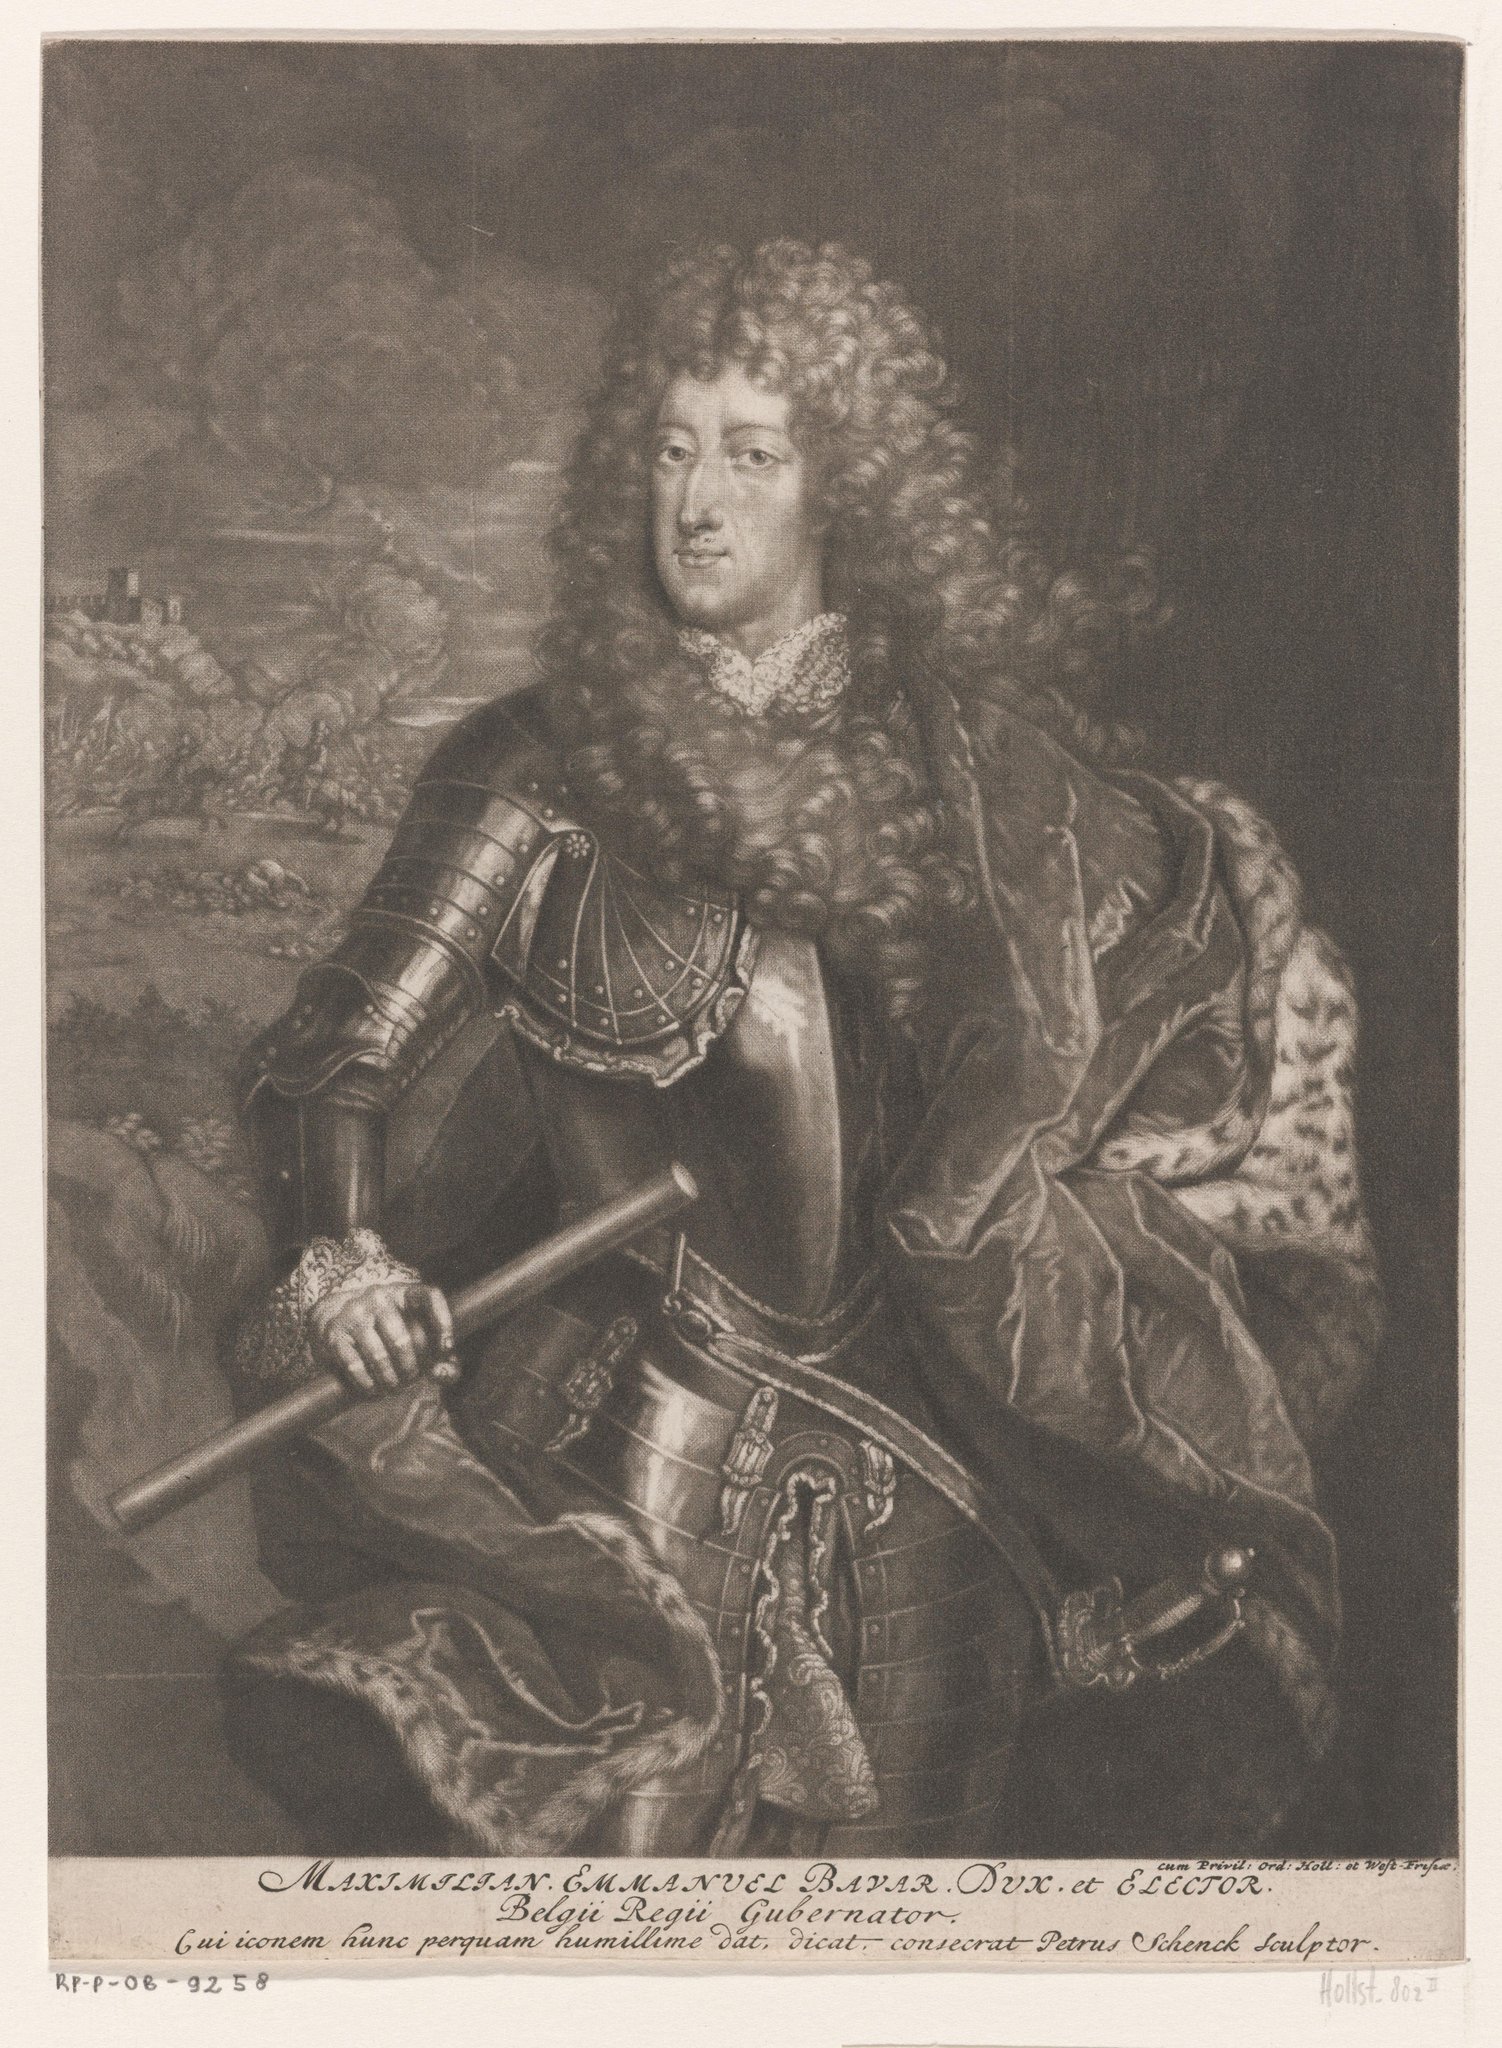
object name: print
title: Portret van Maximiliaan Emanuel II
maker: pieter schenk (i)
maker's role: print maker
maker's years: 1660-1711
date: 1692-1713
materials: paper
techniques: engraving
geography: amsterdam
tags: maximiliaan ii emanuel (keurvorst van beieren), armour, battle, wig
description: Maximiliaan Emanuel II, keurvorst van Beieren en landvoogd van de Zuidelijke Nederlanden. Hij draagt een harnas, een mantel en een lange krulpruik en heeft in de hand een aanvoerderstaf. Op de achtergrond een slagveld.